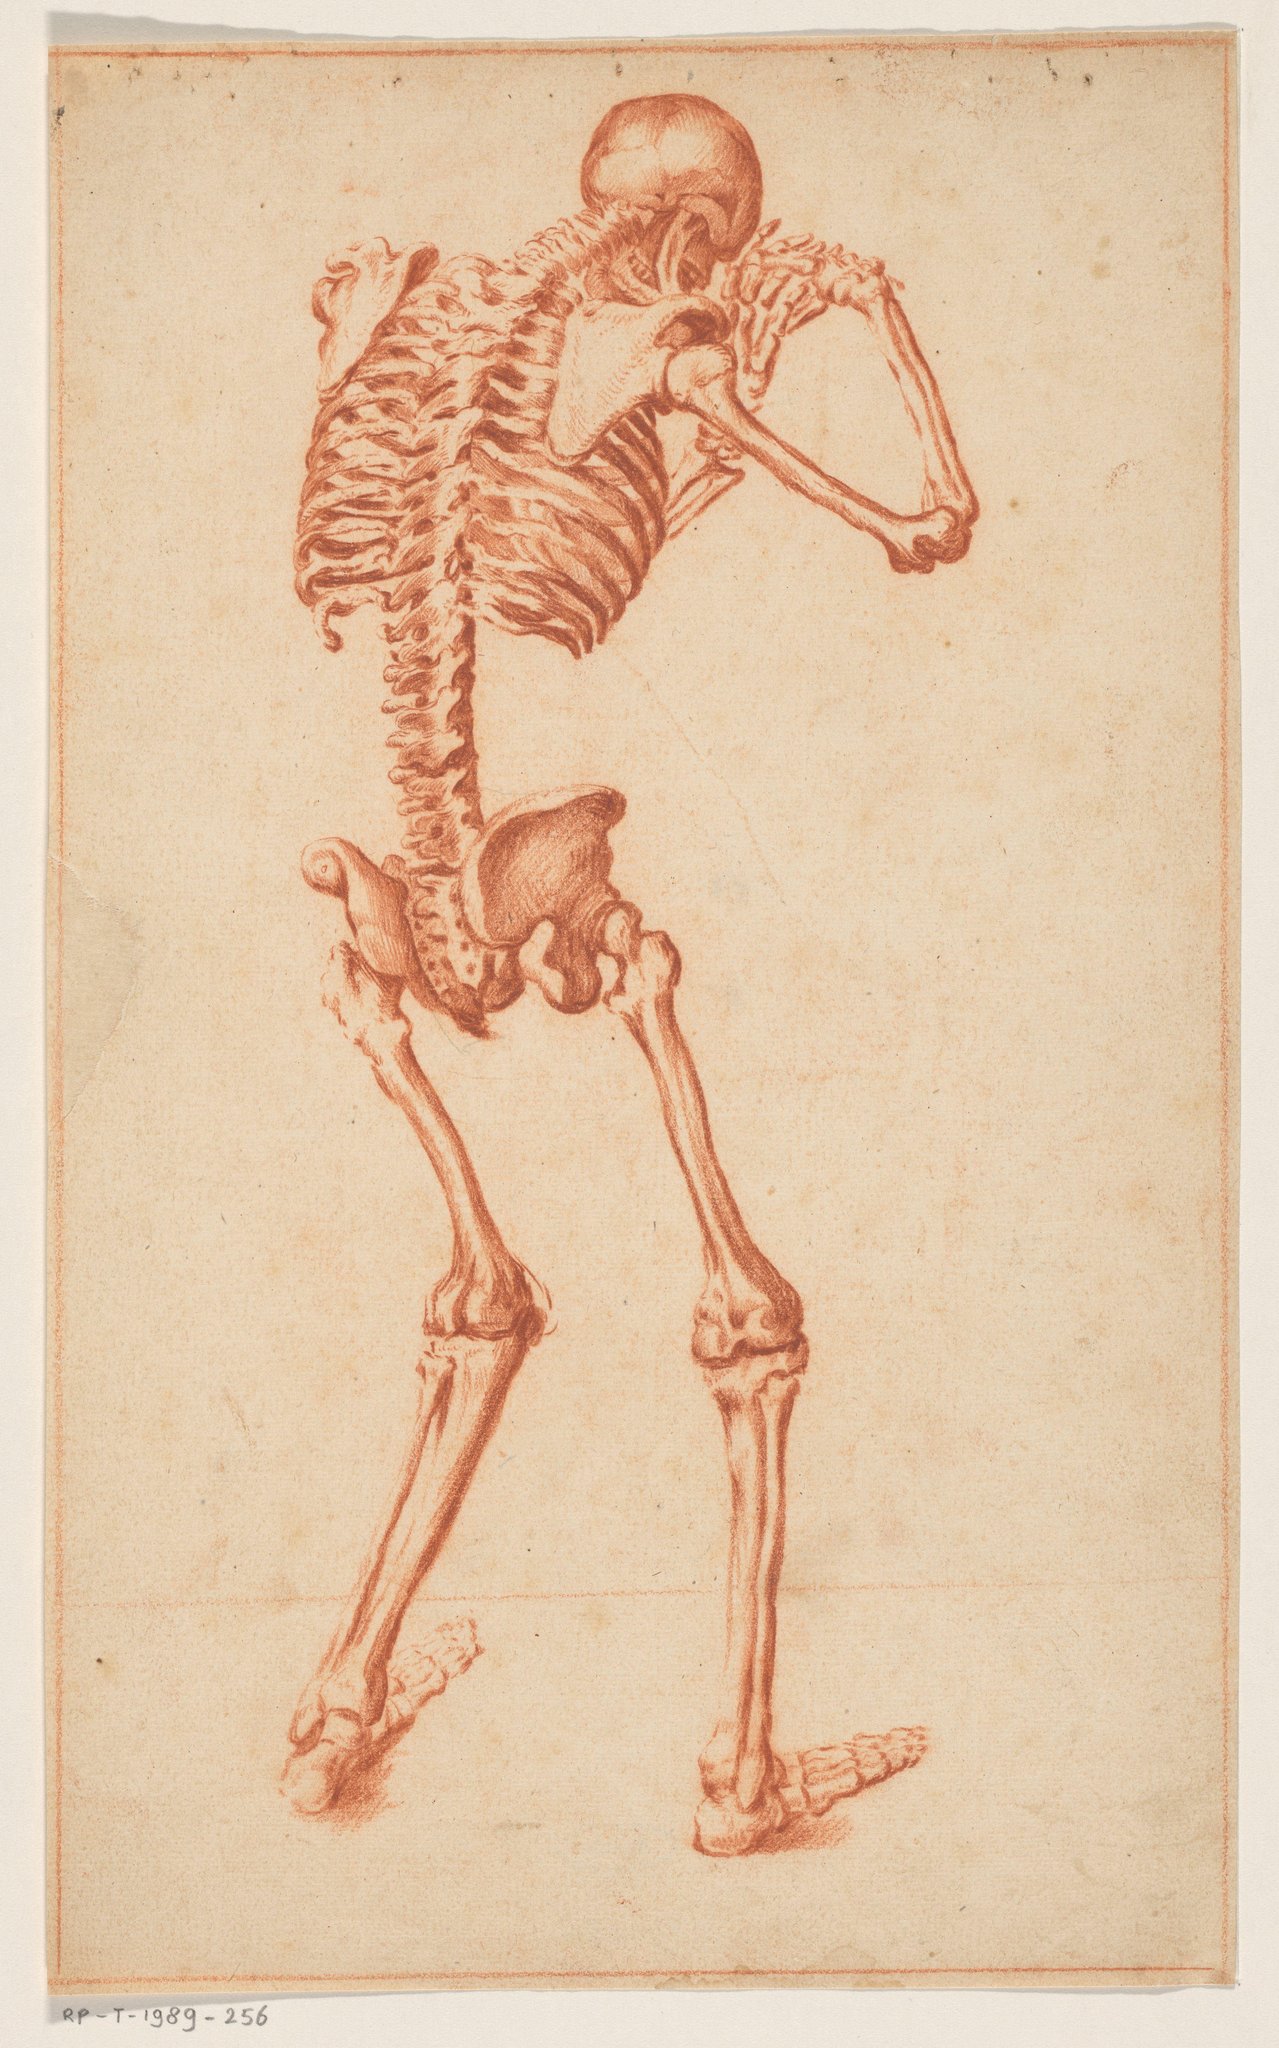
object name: drawing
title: Skelet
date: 1640-1649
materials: chalk, paper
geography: low countries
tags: (human) skeleton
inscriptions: collector's mark: Lugt 2228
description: De houding waarin het skelet is afgebeeld gaat terug tot: Vesalius, Andreas. De humani corporis fabrica libri septem (...). Bazel: Johannes Oporinus, 1543. De illustraties in dit werk worden toegeschreven aan Jan Stefan van Calcar. Latere geïllustreerde anatomische boeken grijpen vaak terug op het werk van Vesalius, zie bijvoorbeeld: Gracht, Jacob van der. Anatomie der wtterlicke deelen van het menschelick lichaem (...). Den Haag: Jacob van der Gracht, 1634. Tekening zit in een omslag met meerdere anatomische tekeningen, genummerd RP-T-1989-258 t/m RP-T-1989-289.